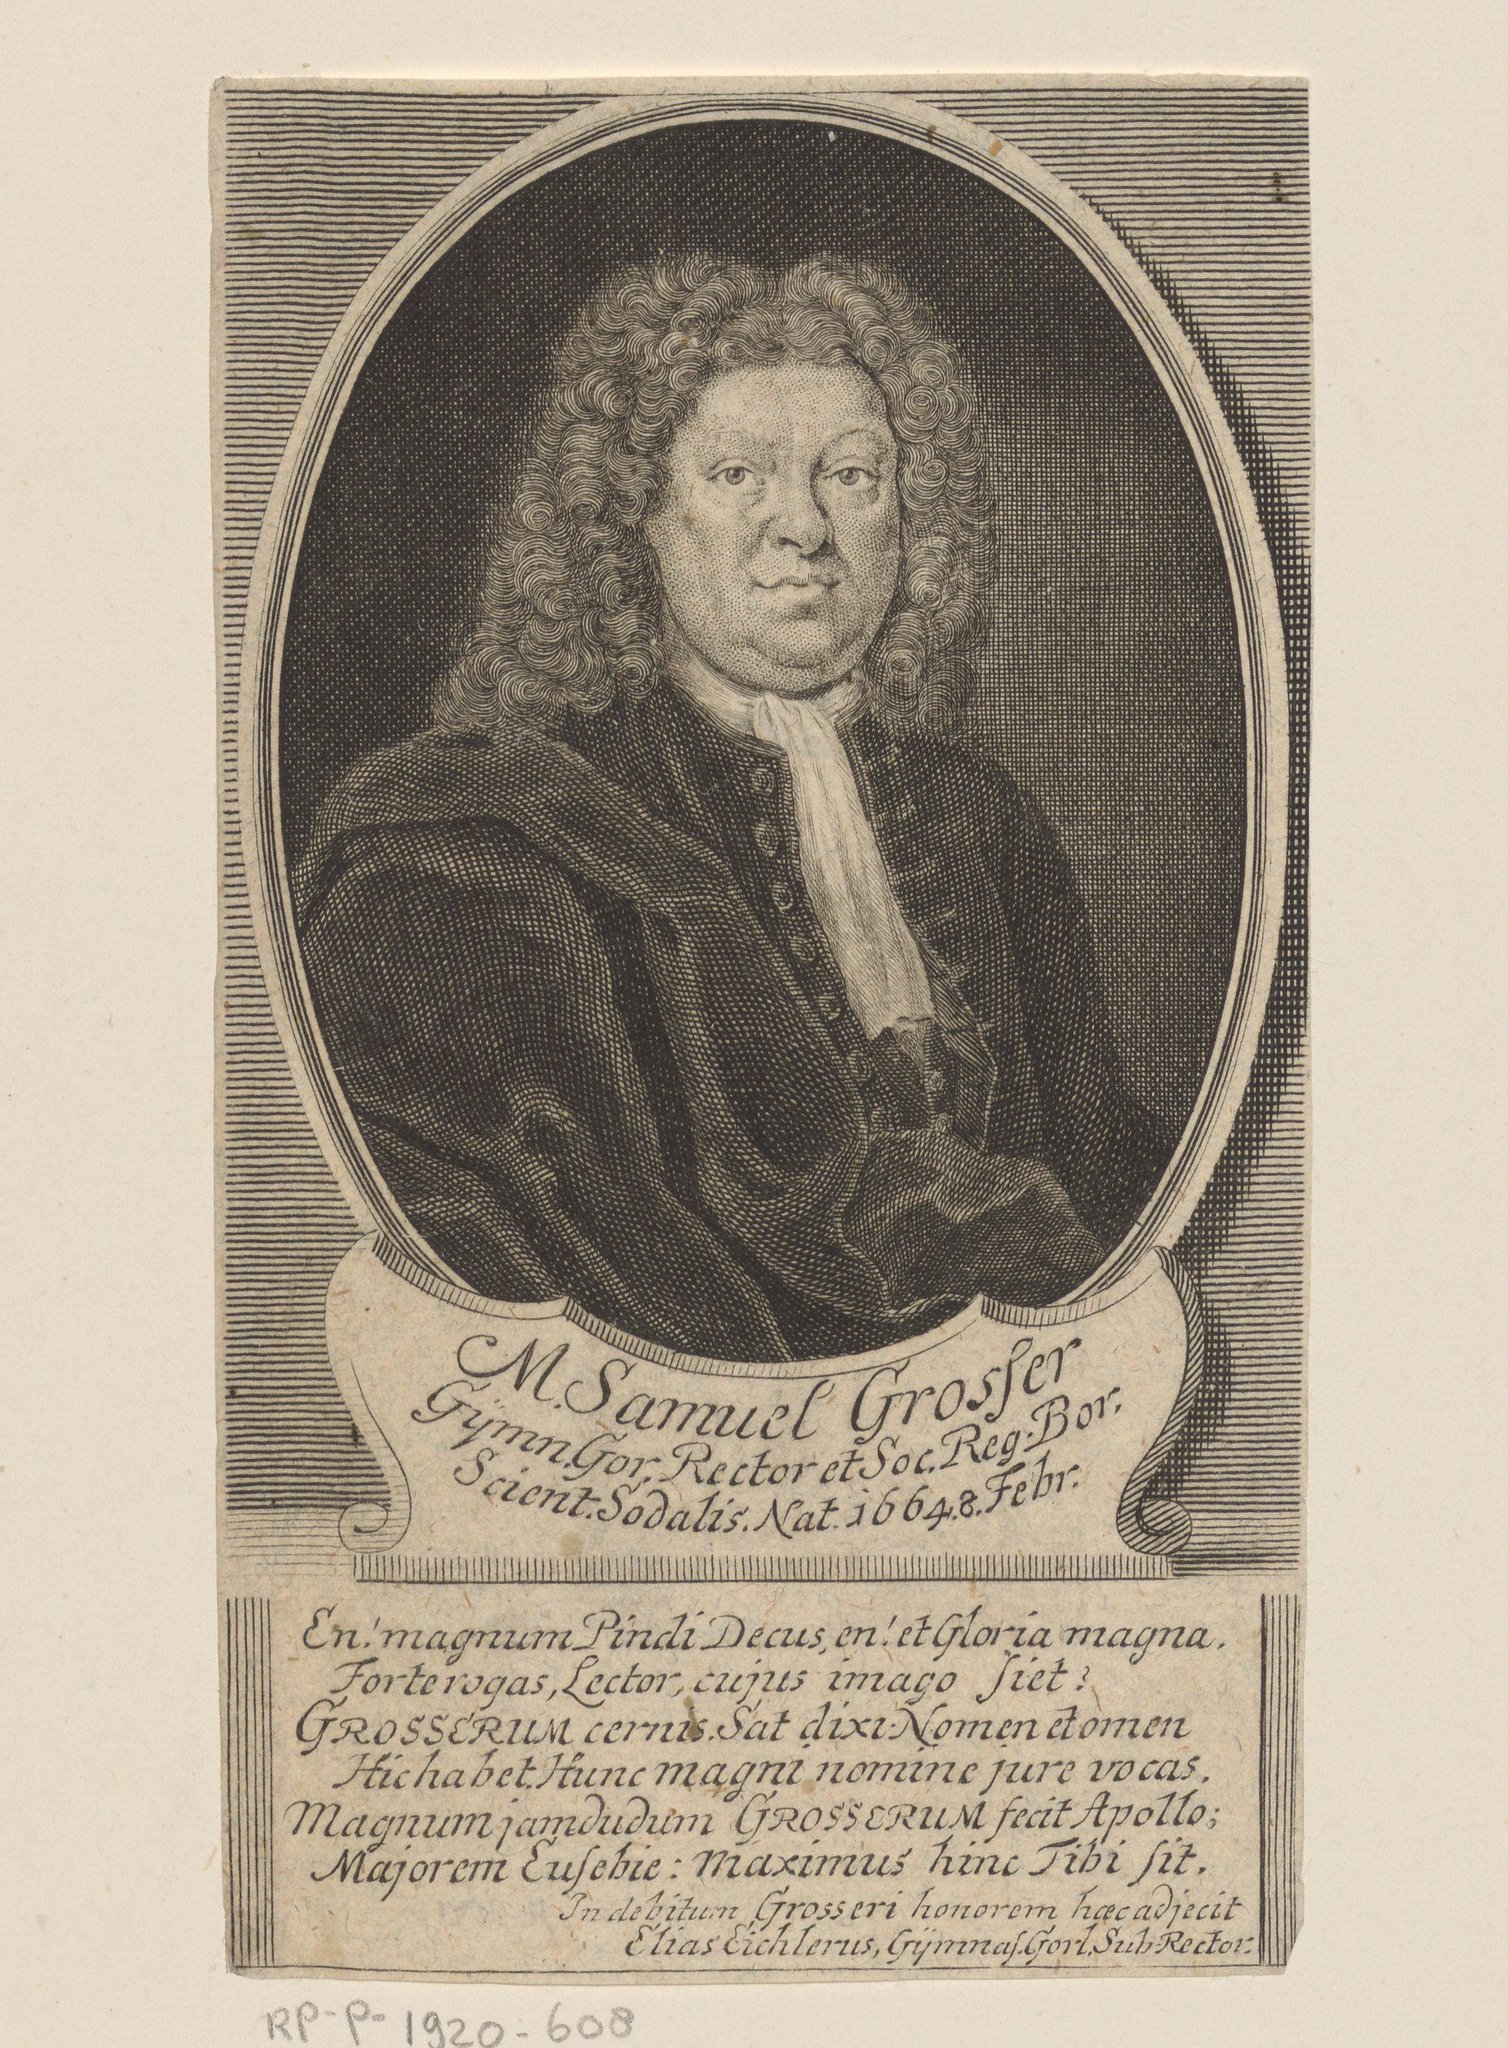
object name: print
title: Portret van Samuel Grosser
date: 1710-1750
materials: paper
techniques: engraving, etching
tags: philology (+ portrait of scholar, scientist), historical persons, portrait of a writer, professor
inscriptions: collector's mark: Lugt 2228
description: Tekst in het Latijn in de cartouche en in de ondermarge.